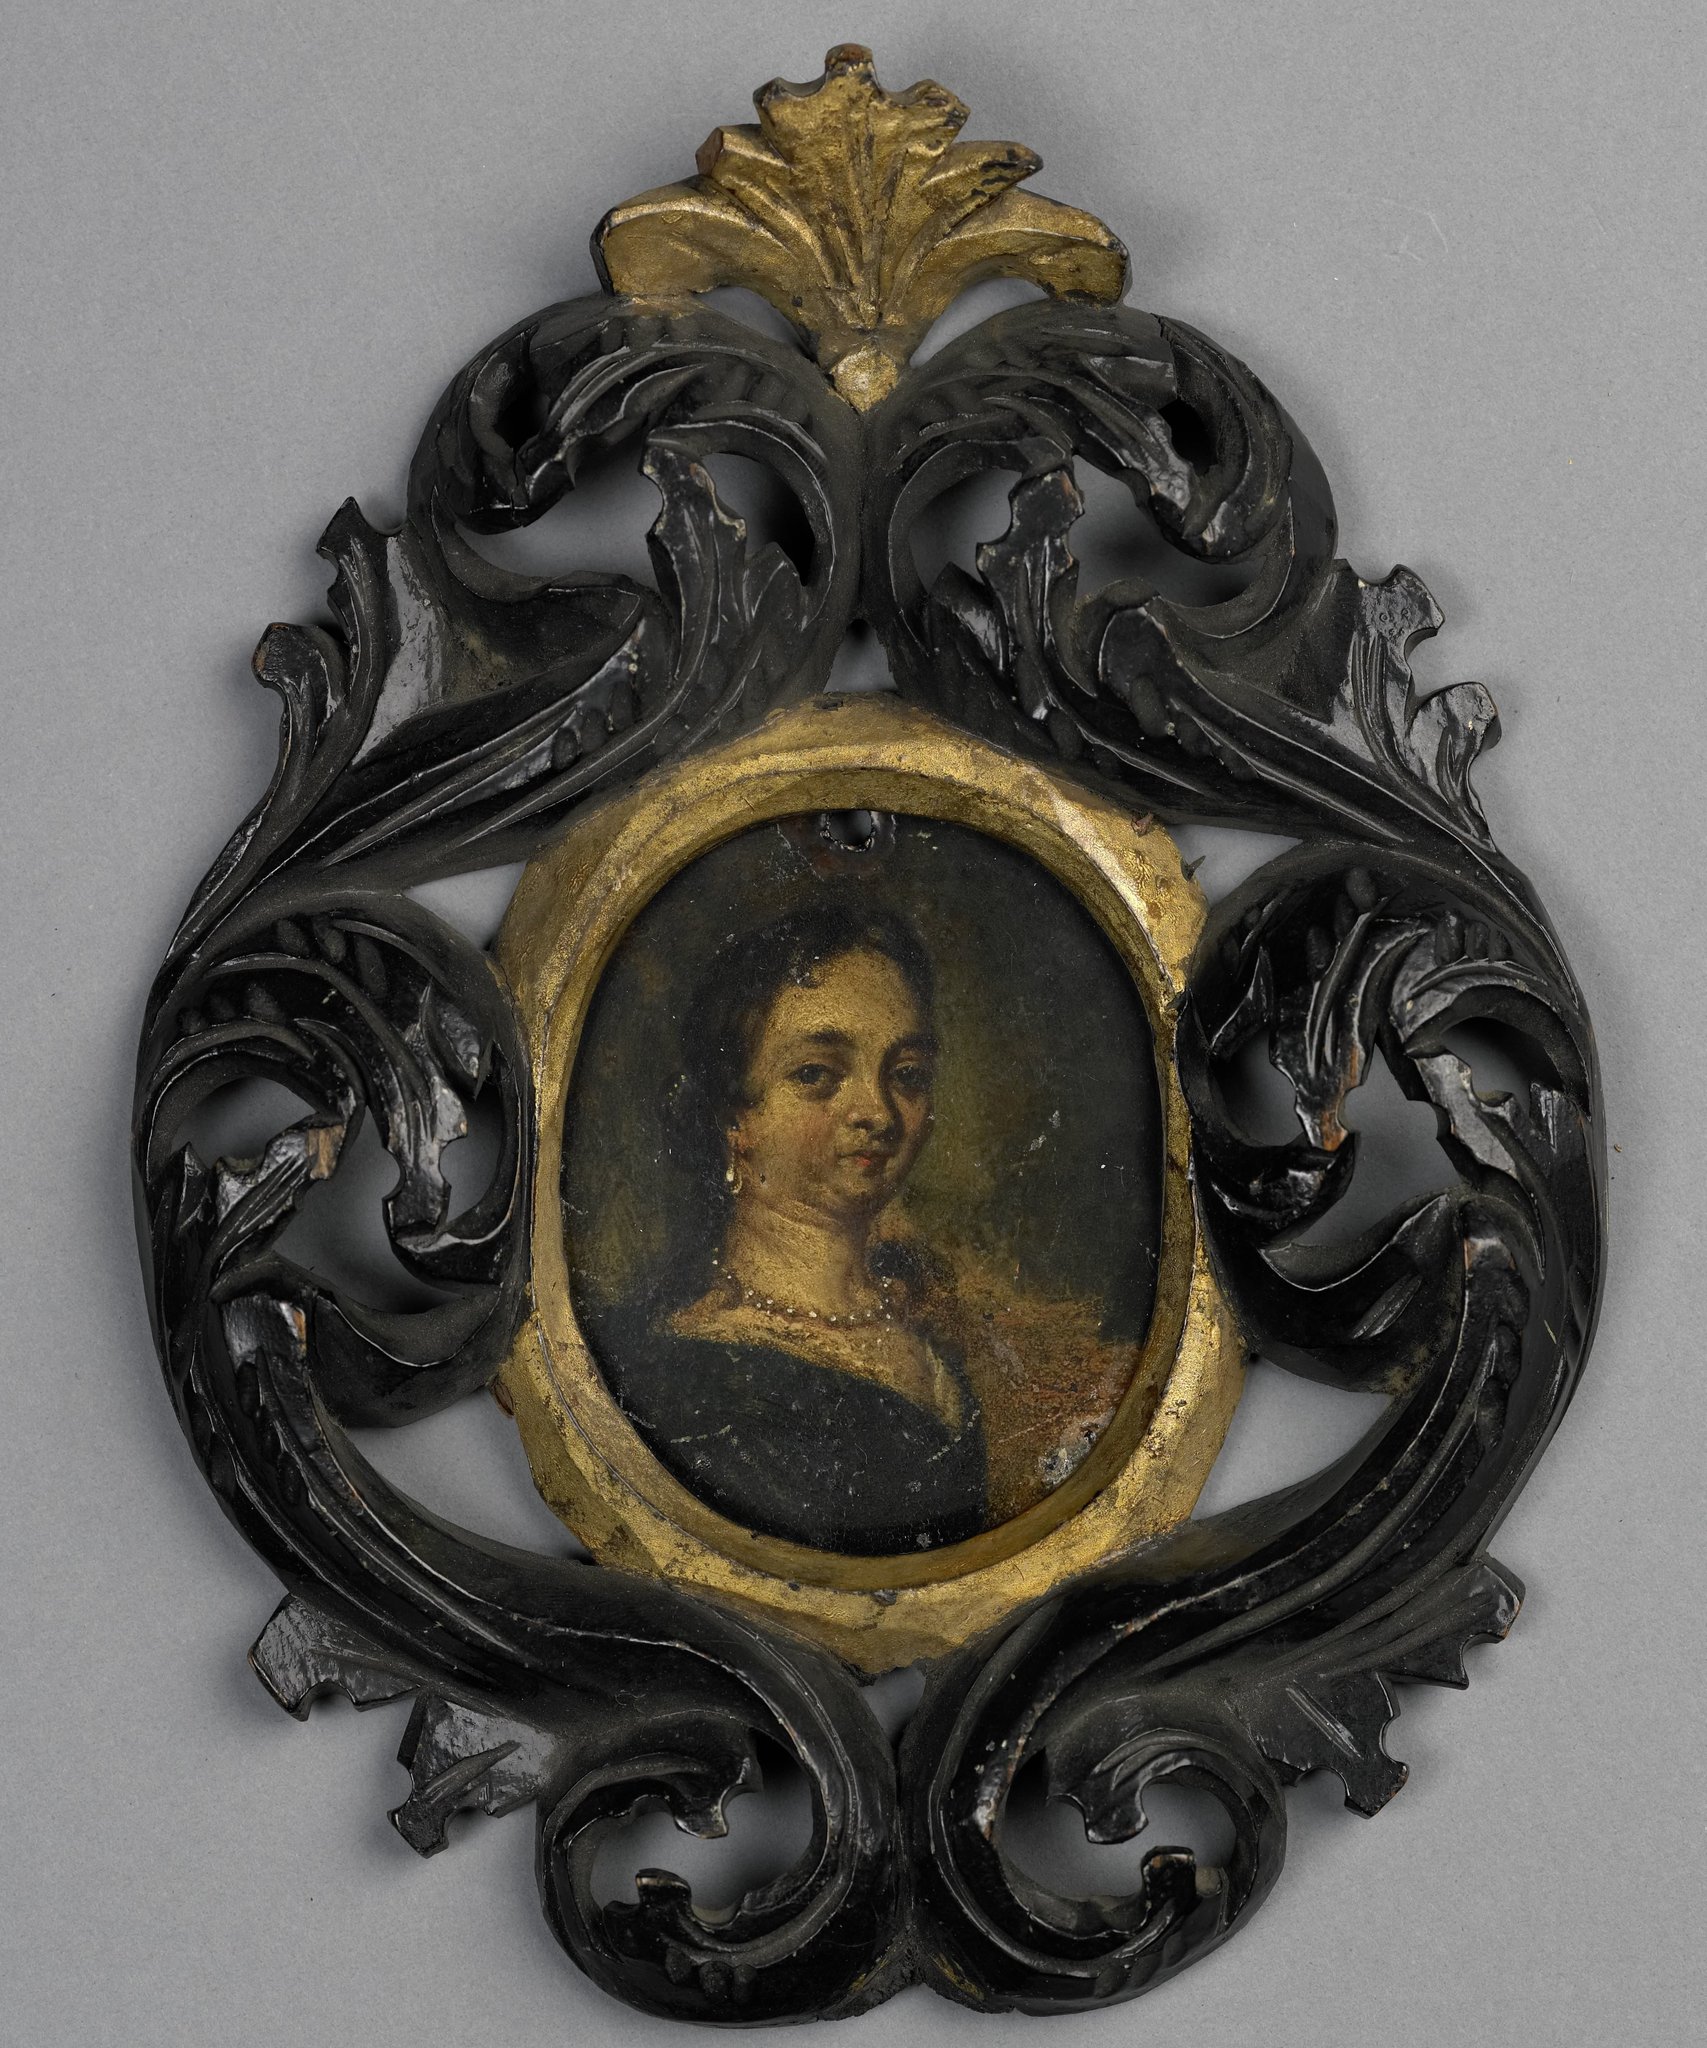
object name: painting, miniature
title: Vrouwenportret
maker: Anonymous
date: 1675-1700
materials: copper, oil, wood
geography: europe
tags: anonymous historical person portrayed - bb - woman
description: Ovale portret van een vrouw in een versierde houten lijst van uitgesneden blaadjes, zwart geschilderd met een gouden plume op de bovenkant.